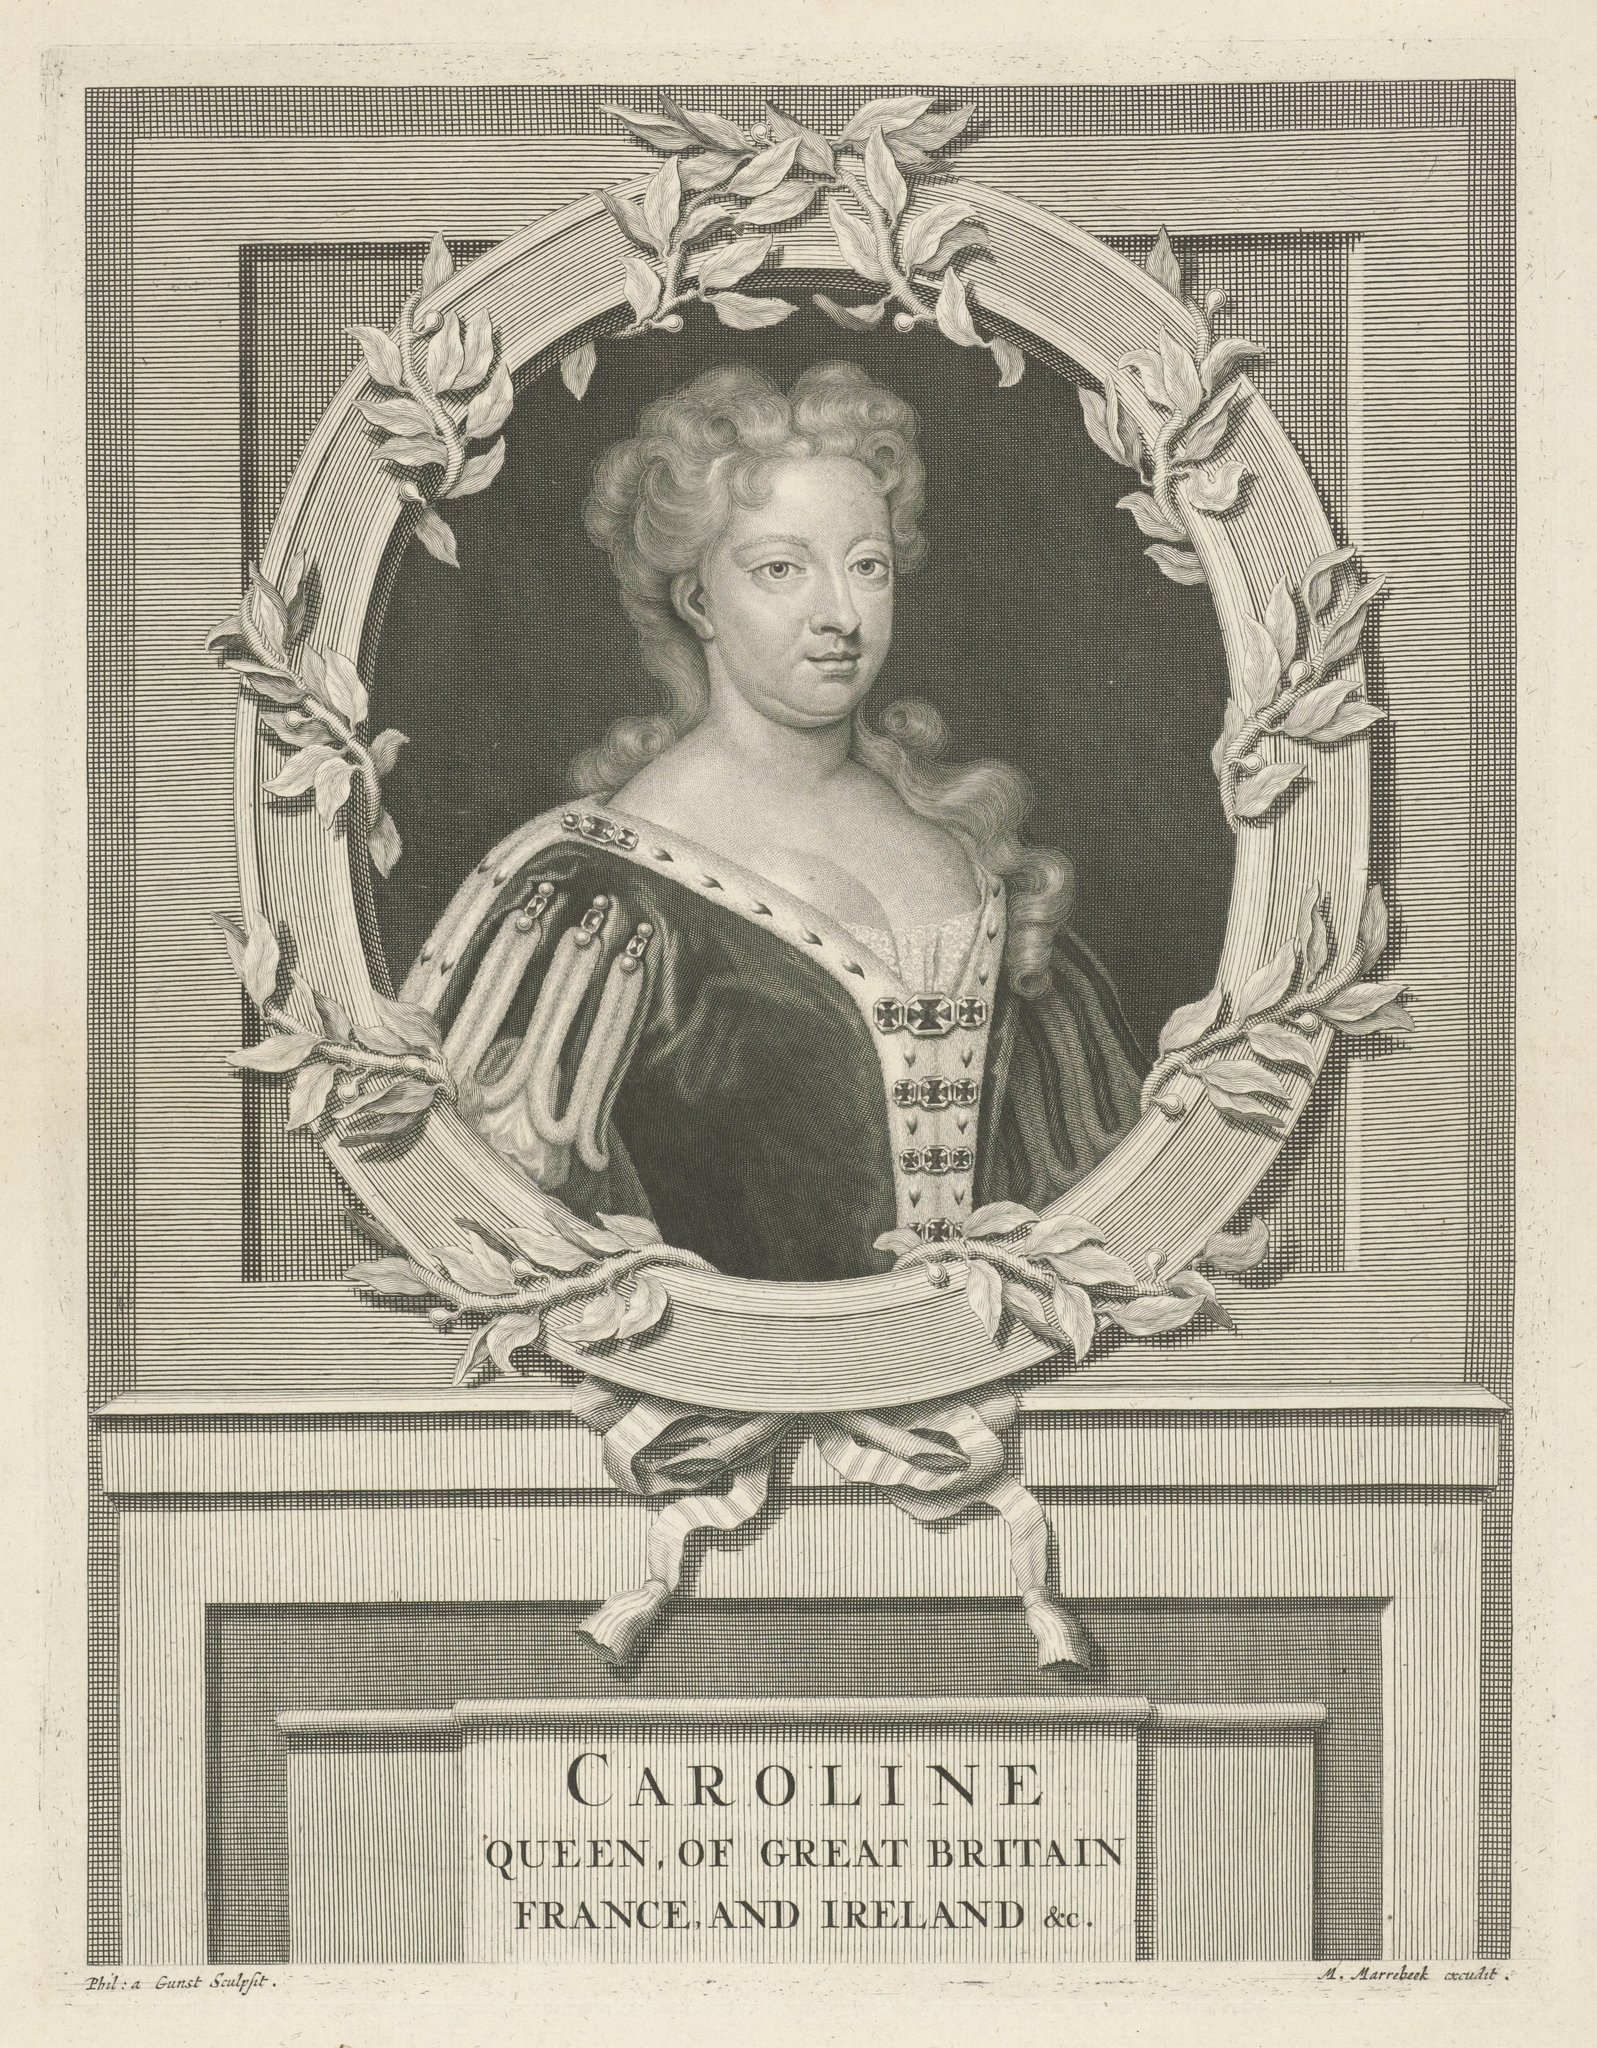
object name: print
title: Portret van Caroline van Anspach, koningin van Groot-Brittannië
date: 1727-1732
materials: paper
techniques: engraving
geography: amsterdam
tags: london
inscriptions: collector's mark: Lugt 2228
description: Caroline van Anspach, koningin van Groot-Brittannië en vrouw van koning George II.